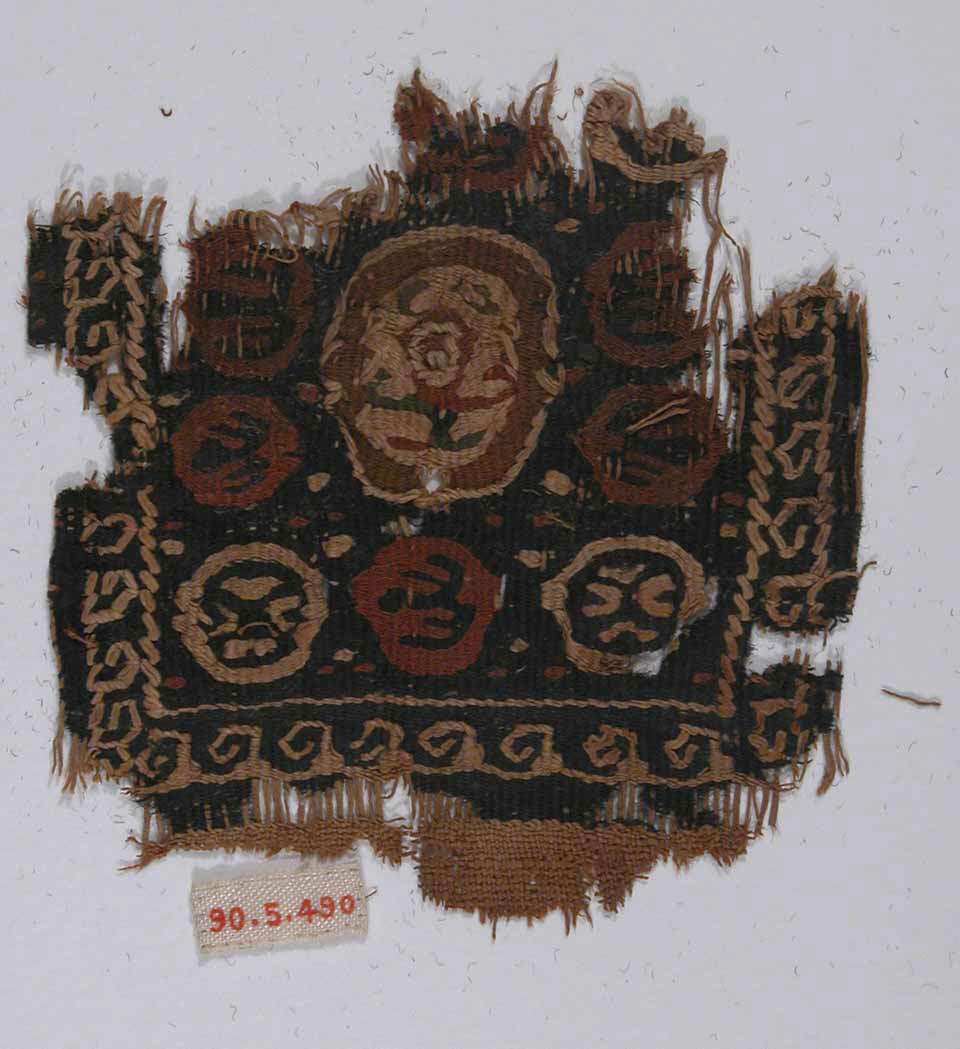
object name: textile fragment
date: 301-500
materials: linen, wool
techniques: weave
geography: egypt